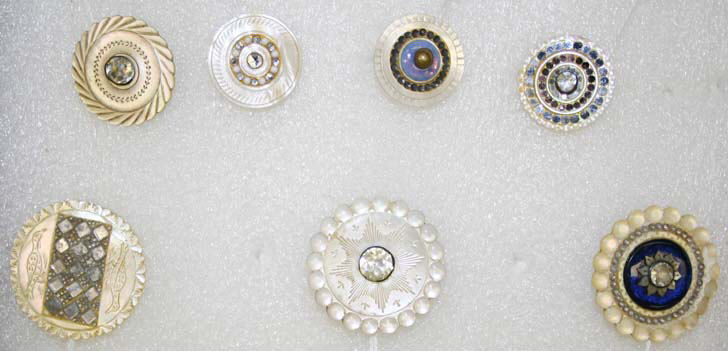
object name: button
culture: french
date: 1780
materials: metal, mother of pearl, paste